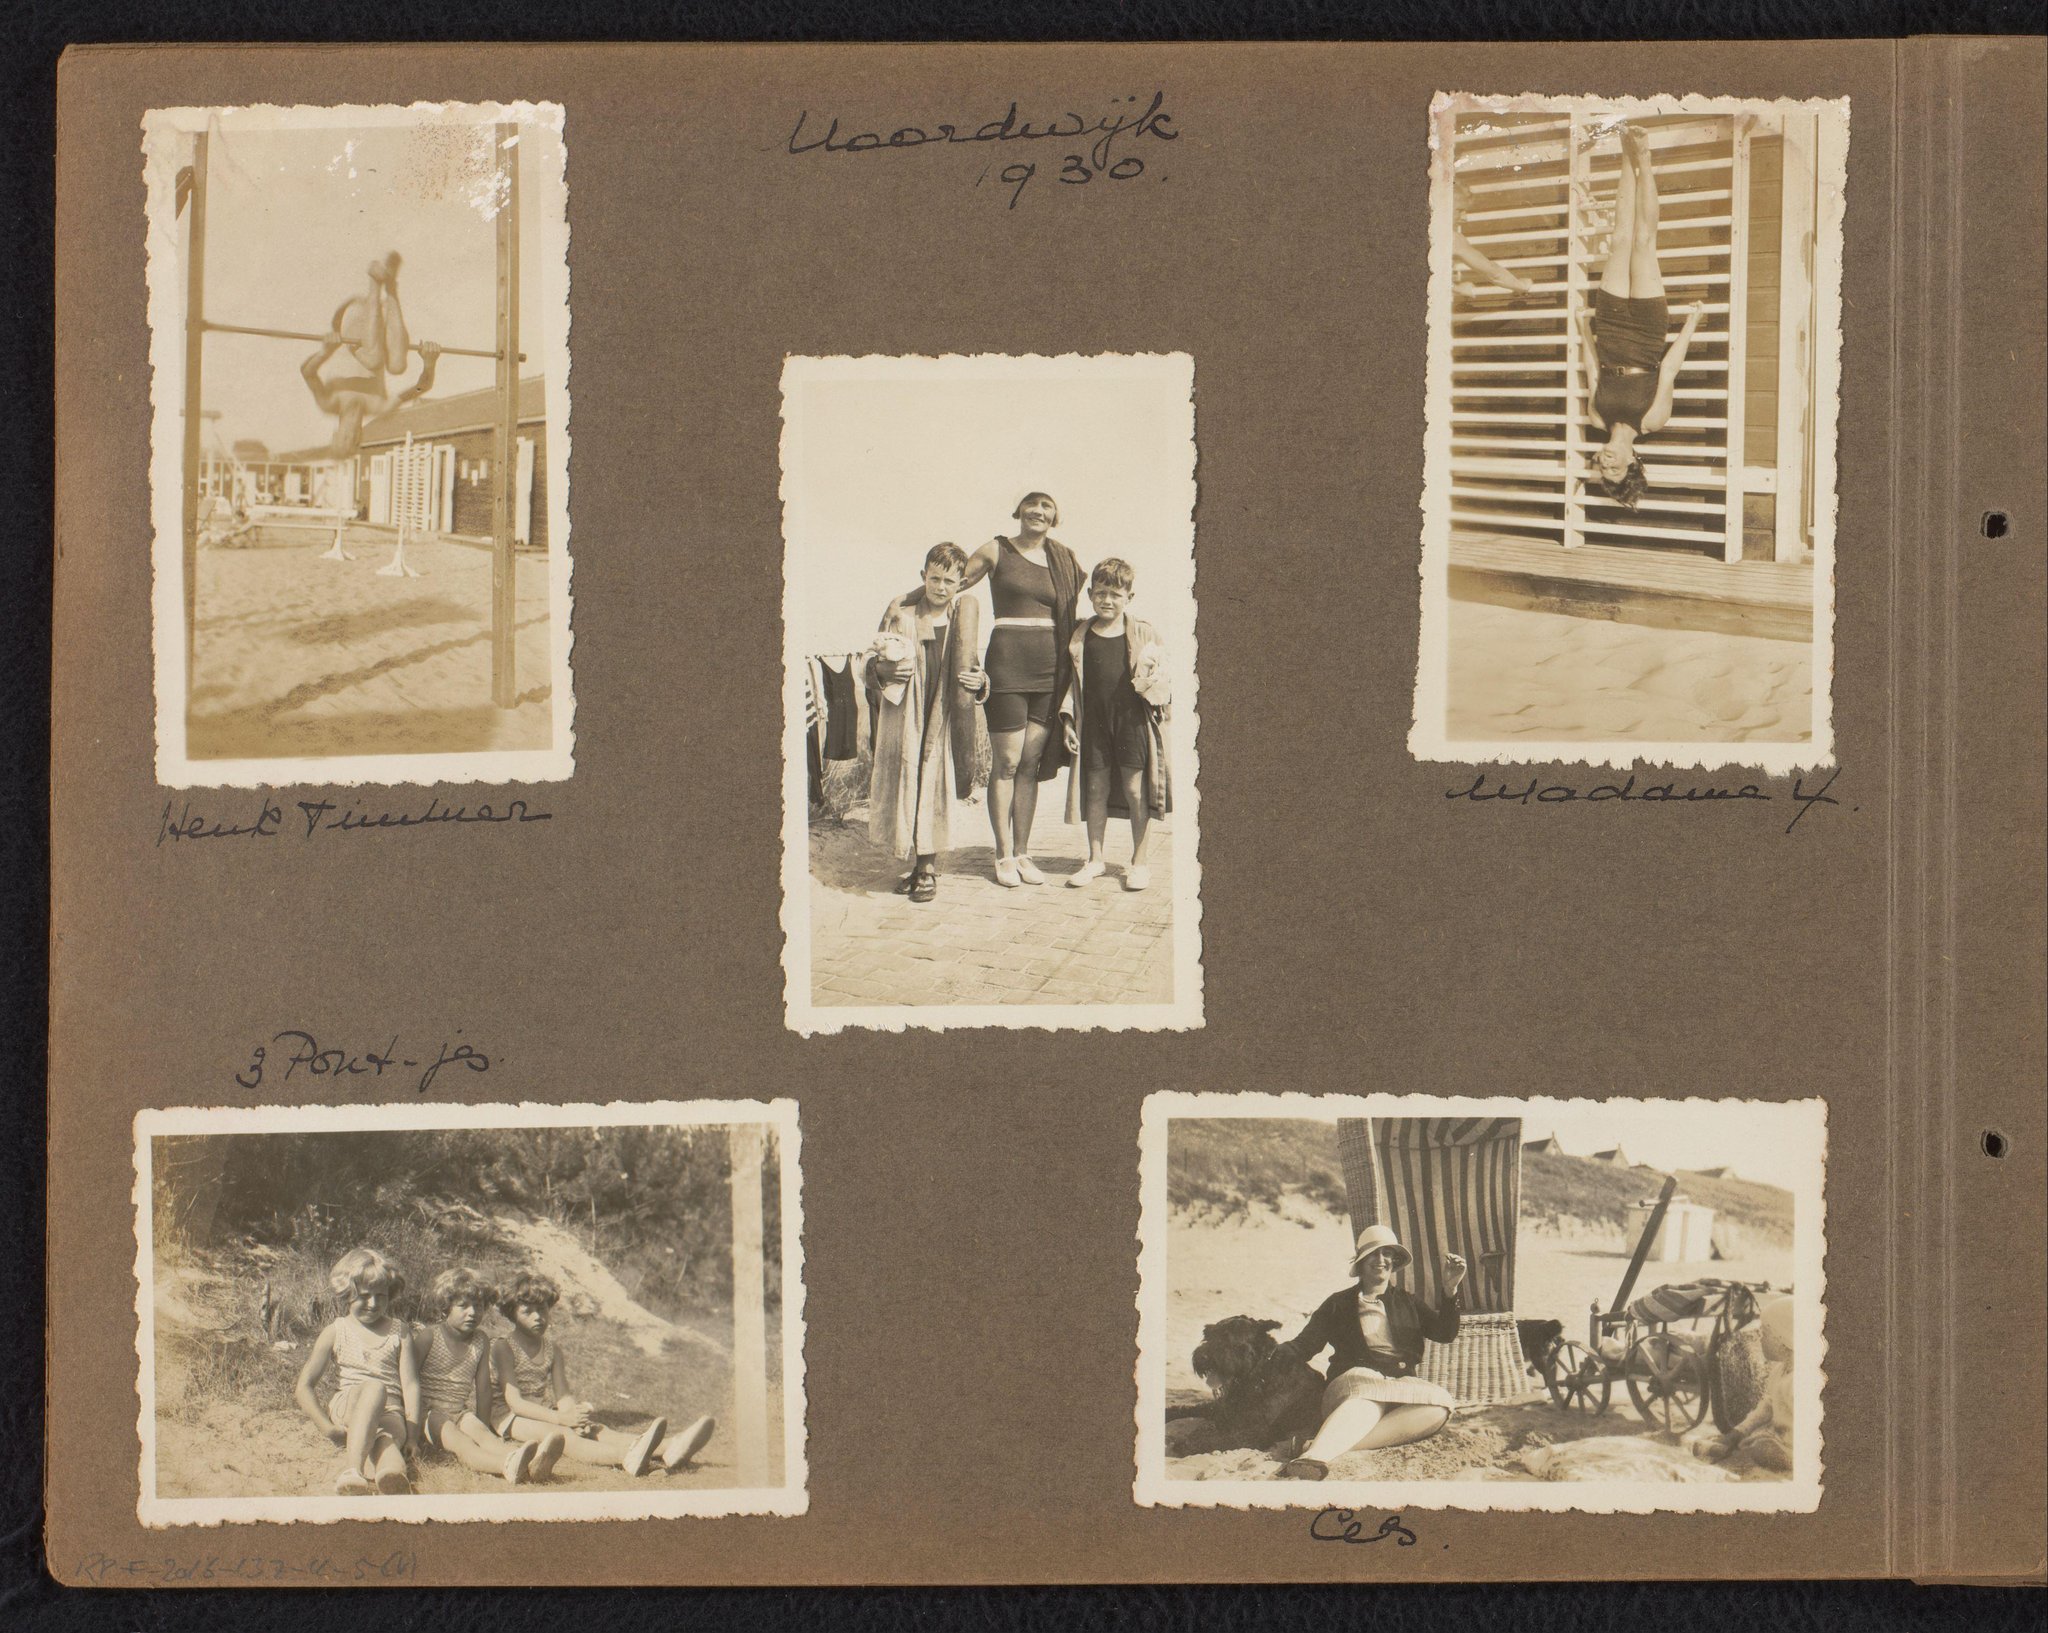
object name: album leaf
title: Loentje Furnée met kinderen op het strand van Noordwijk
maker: carolina frederika onnen (lien/loen)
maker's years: 1896-1983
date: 1930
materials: paper, cardboard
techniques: gelatin silver print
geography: noordwijk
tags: amsterdam, carolina frederika onnen (lien/loen), beach (as place of recreation)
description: Deze foto's zijn onderdeel van een album.